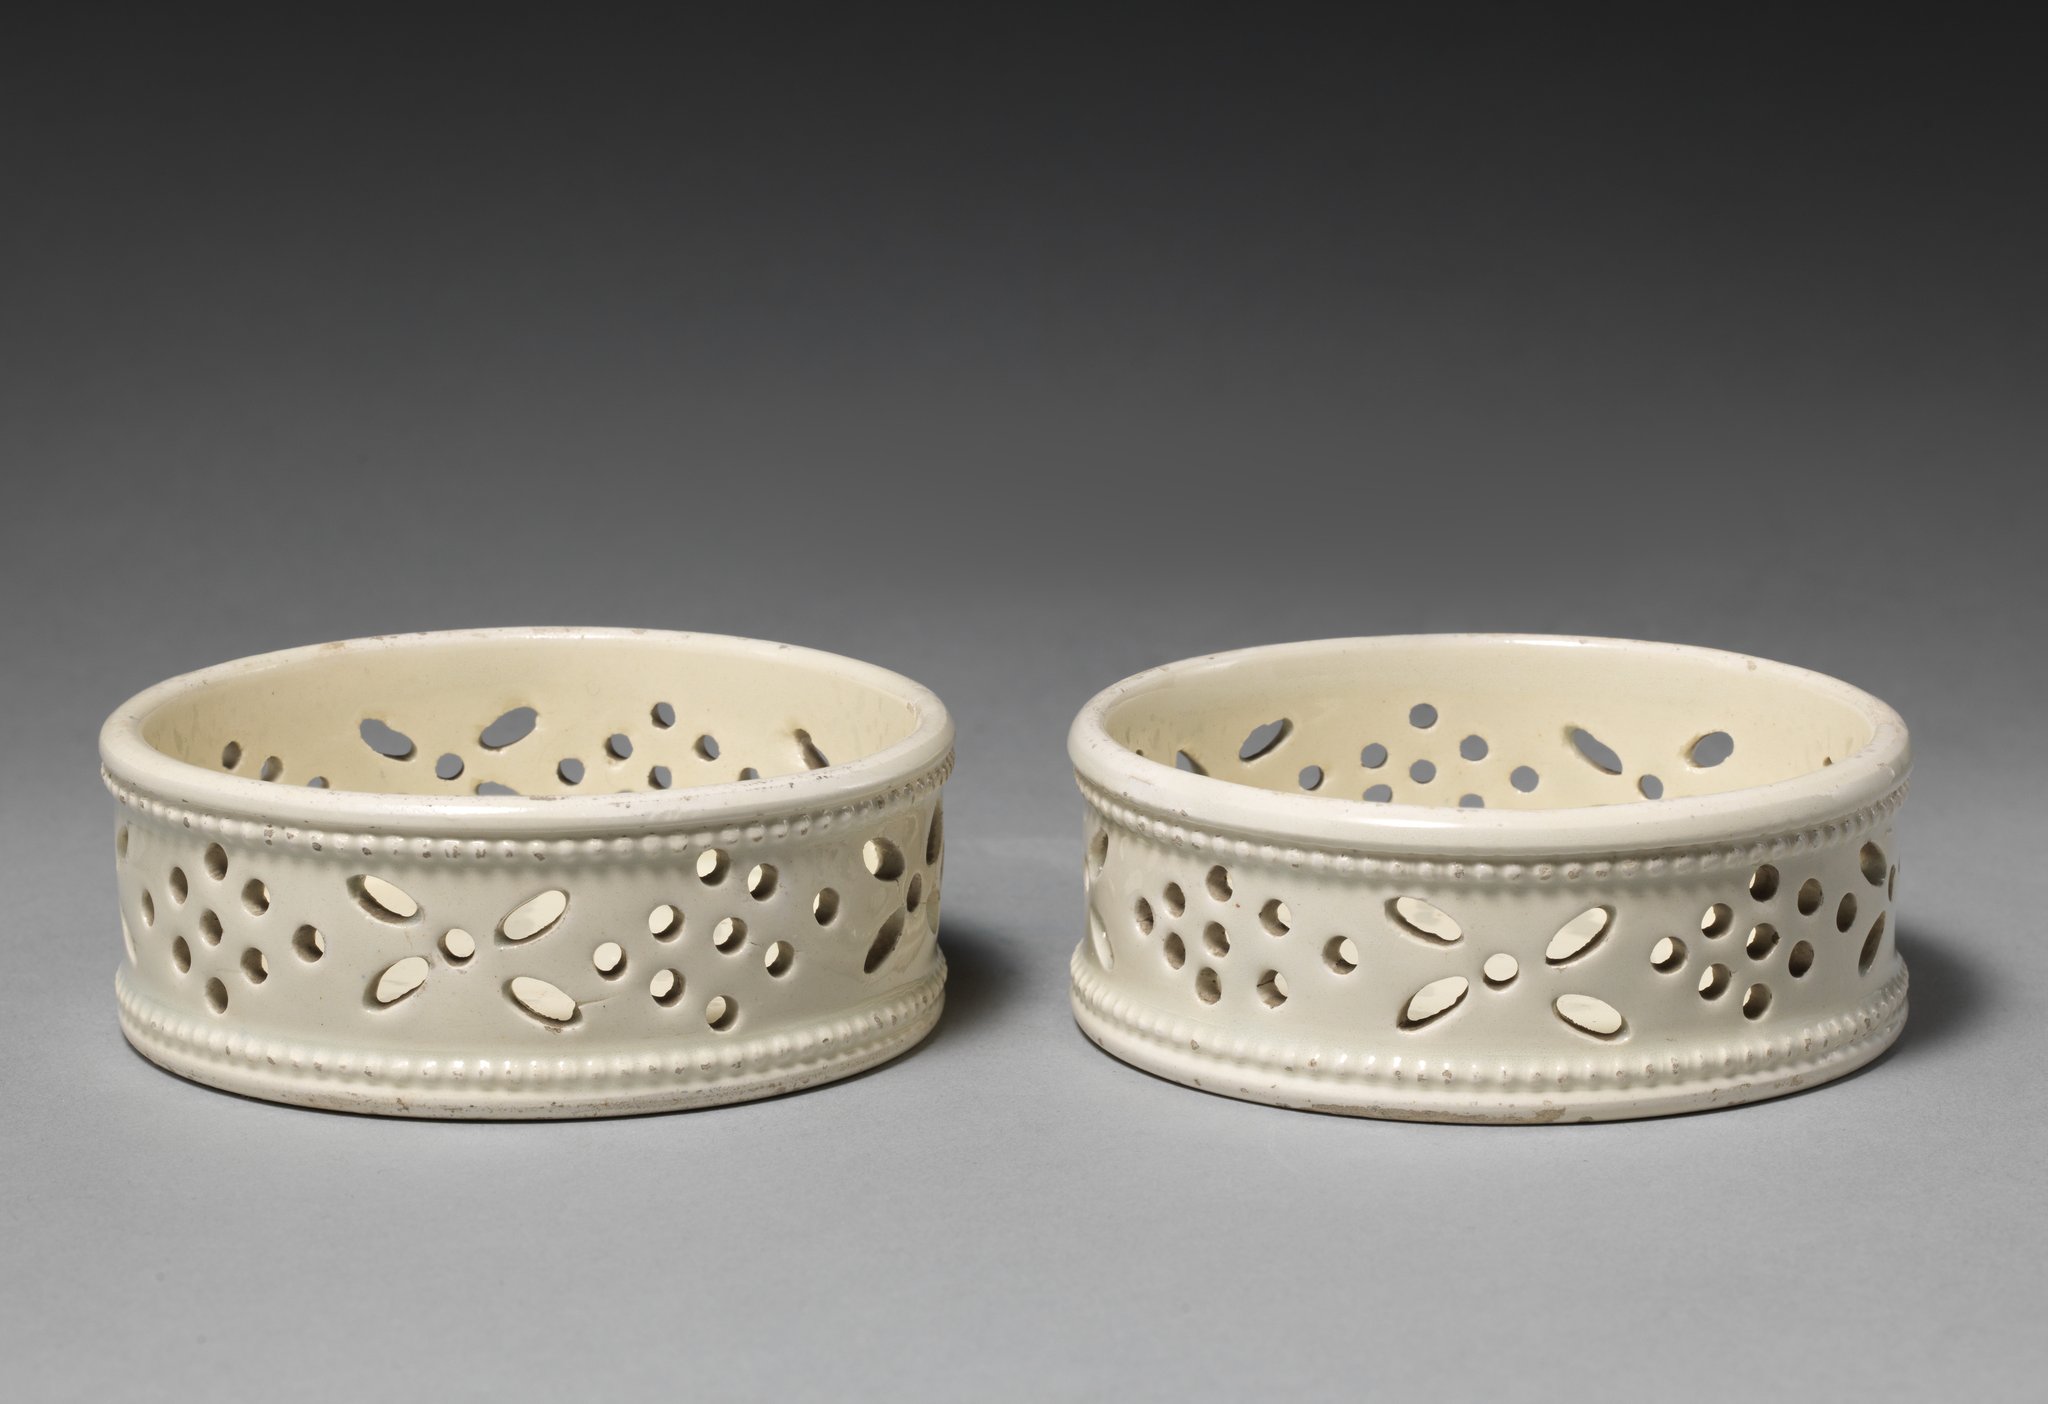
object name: wine glass stand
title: Pair of wine glass stands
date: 1767-1800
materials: creamware